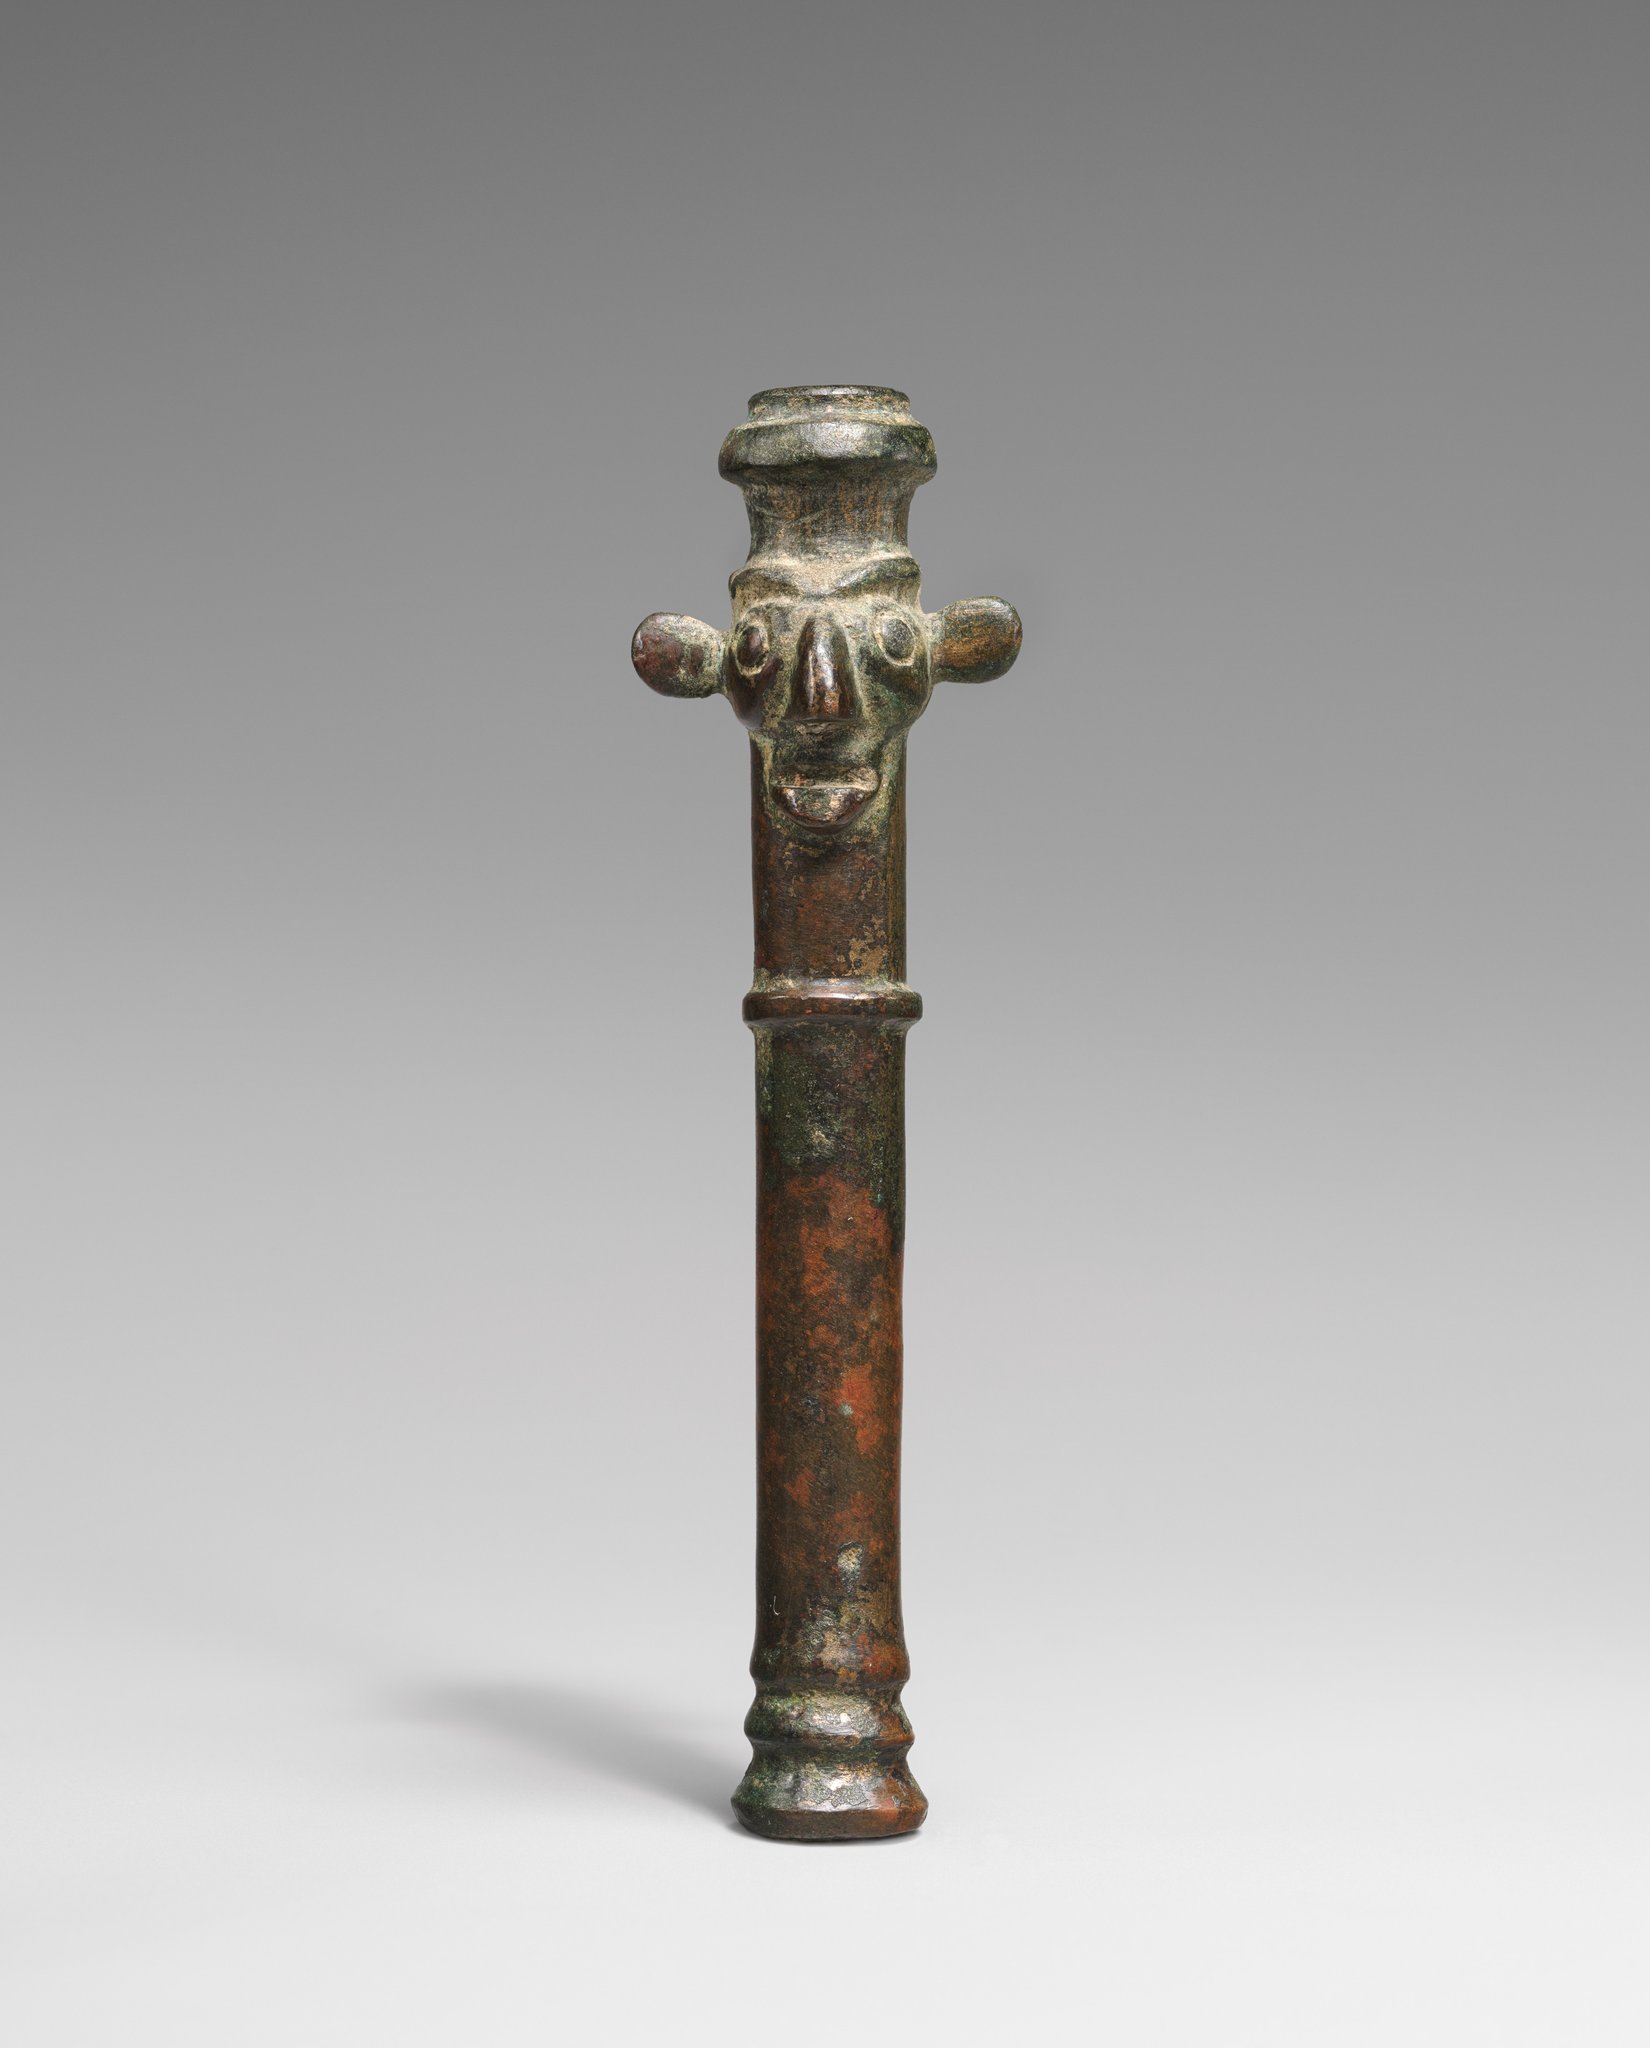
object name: tube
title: Anthropomorphic tube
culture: iranian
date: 800-601 BCE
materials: bronze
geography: iran, probably from luristan